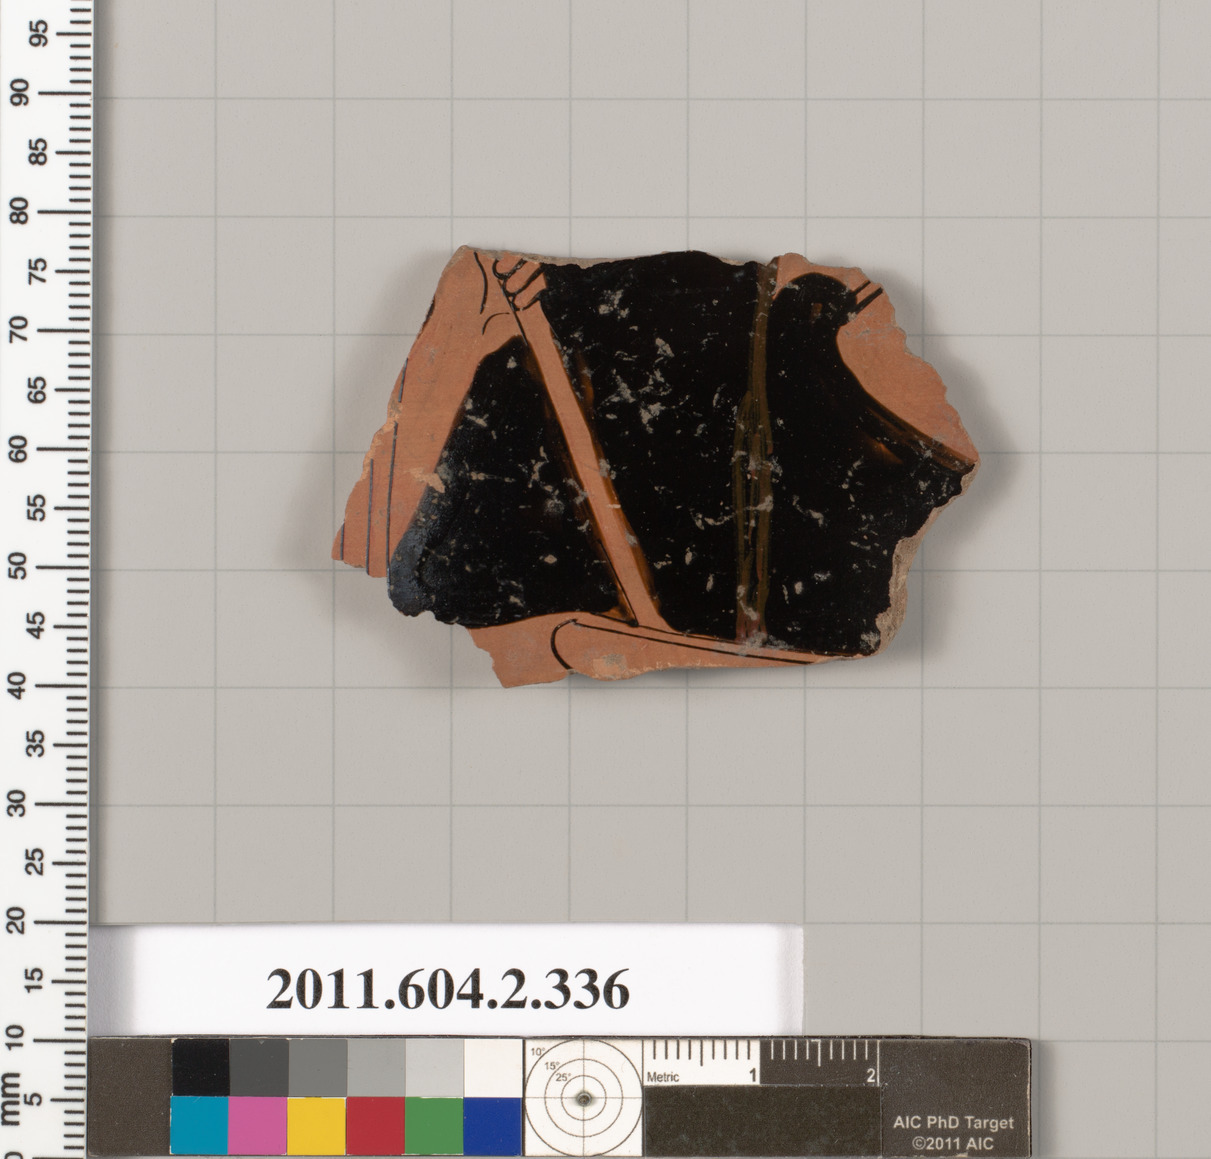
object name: column krater fragment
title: Terracotta fragment of a column-krater (bowl for mixing wine and water)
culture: greek, attic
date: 460-440 BCE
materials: terracotta